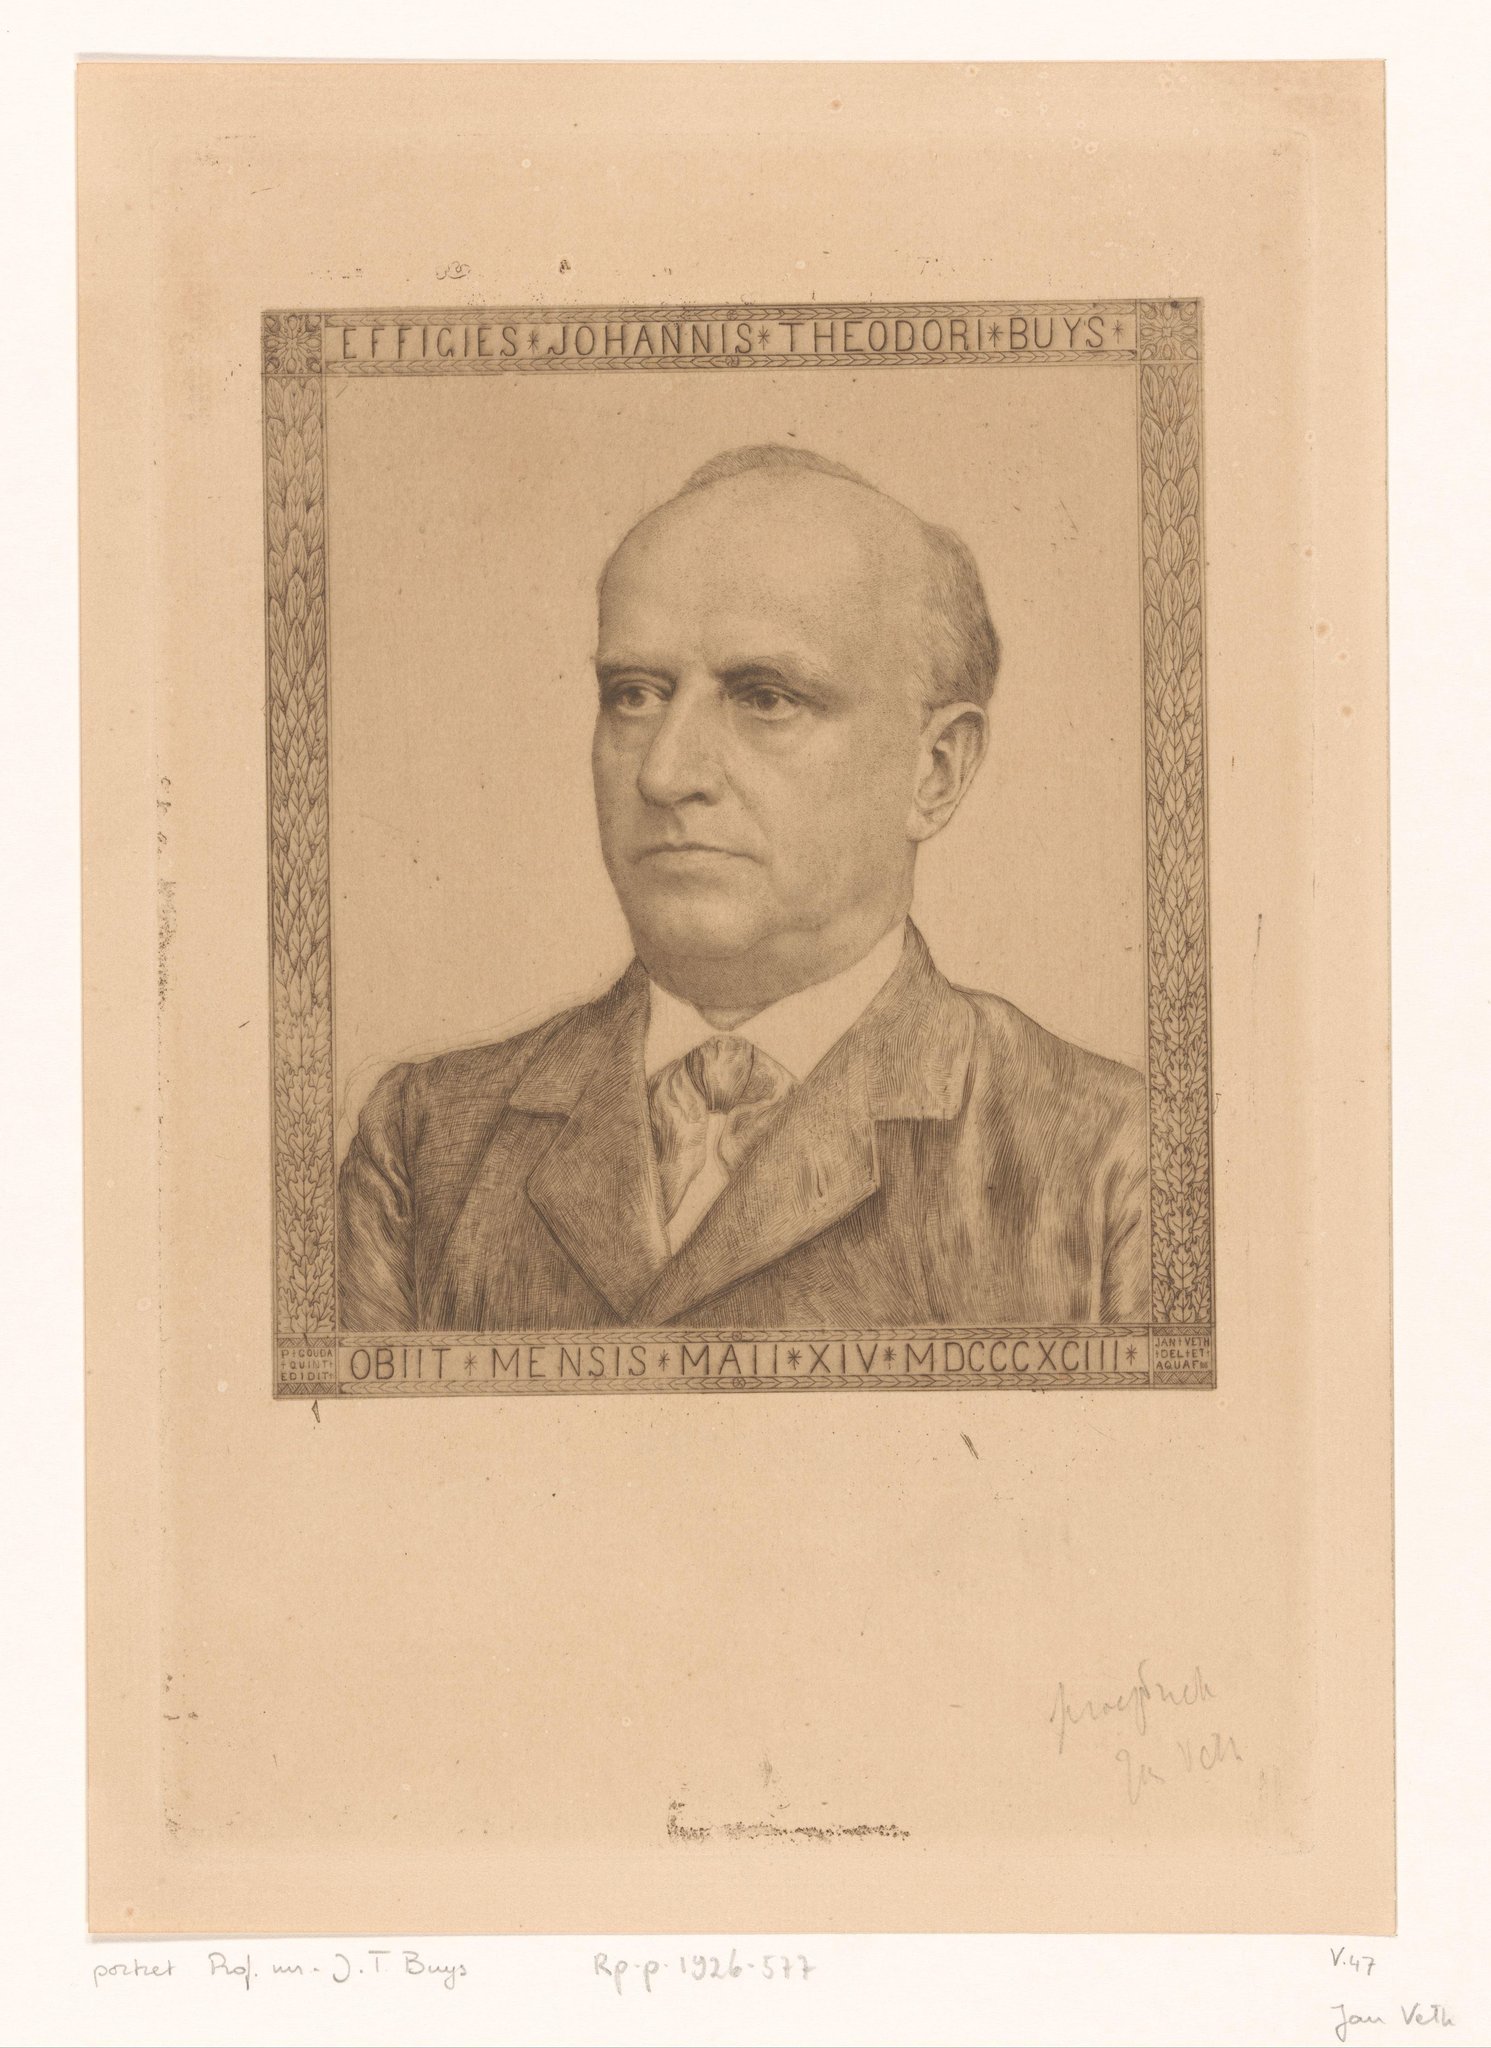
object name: print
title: Portret van Johannes Theodoor Buys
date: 1893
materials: paper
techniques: etching, intaglio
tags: historical persons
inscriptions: collector's mark: Lugt 2228